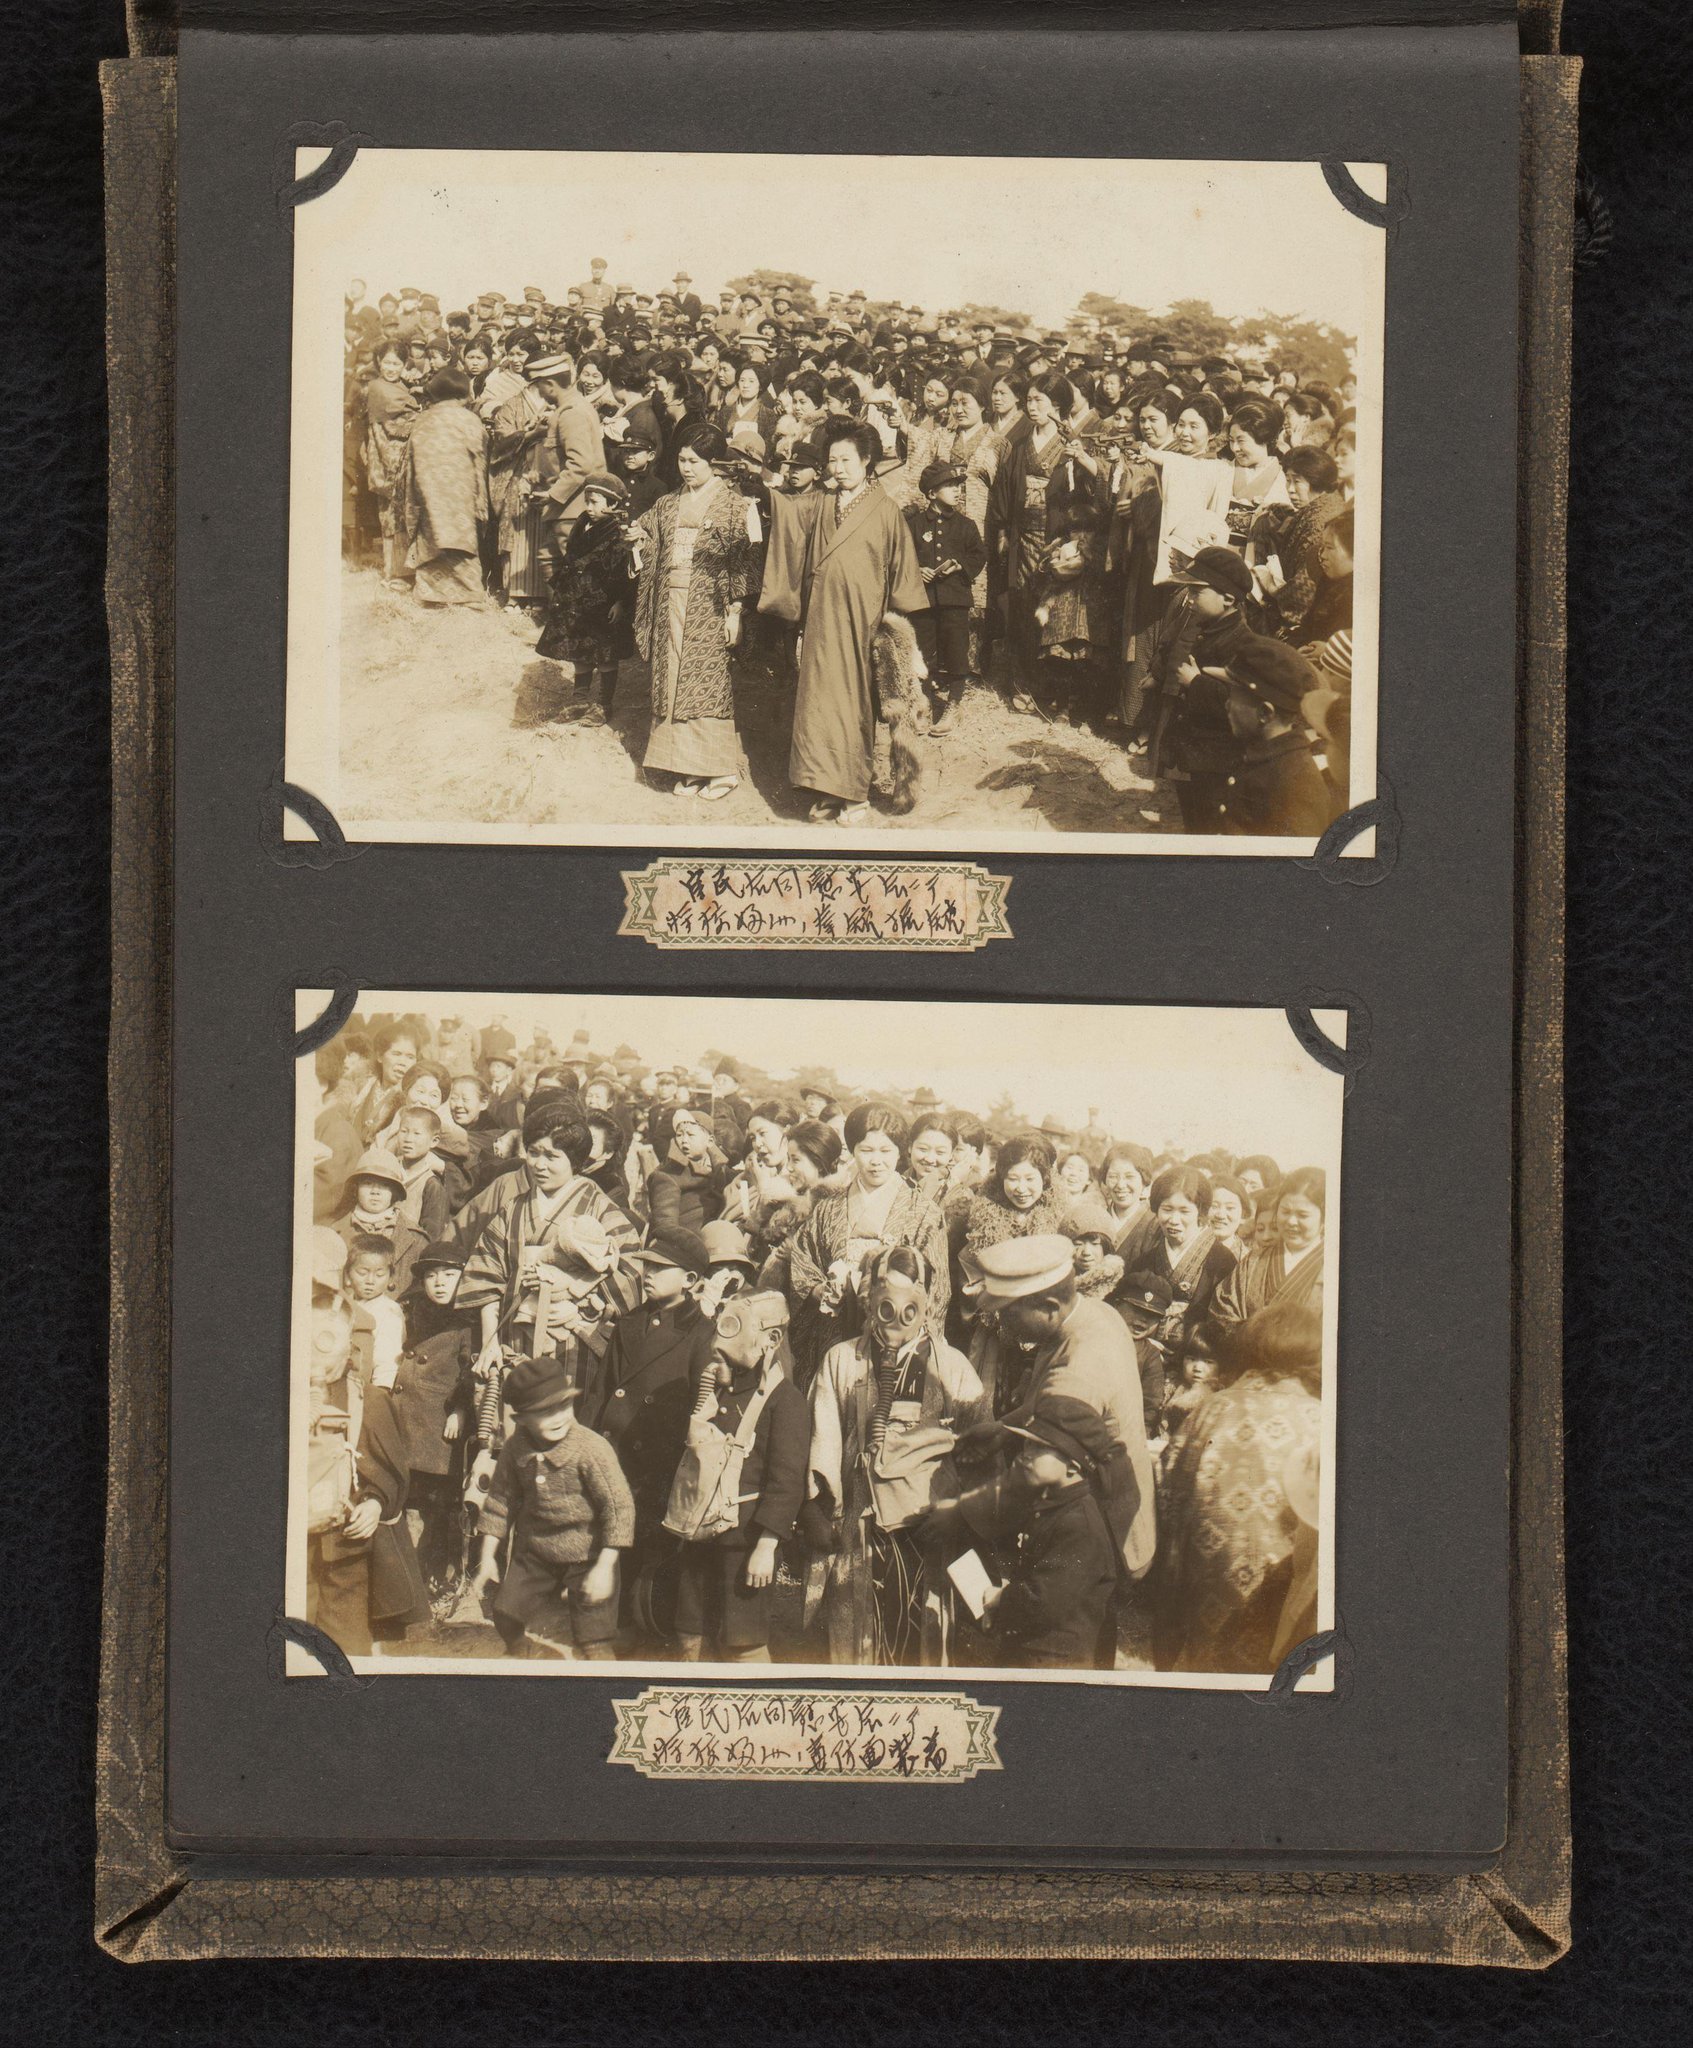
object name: album leaf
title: Vrouwen en kinderen met gasmaskers en pistolen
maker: Anonymous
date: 1930-1940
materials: paper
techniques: gelatin silver print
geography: korea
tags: protective weapons, firearms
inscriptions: inscription: ‘[...]’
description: Deze foto's zijn onderdeel van een album.